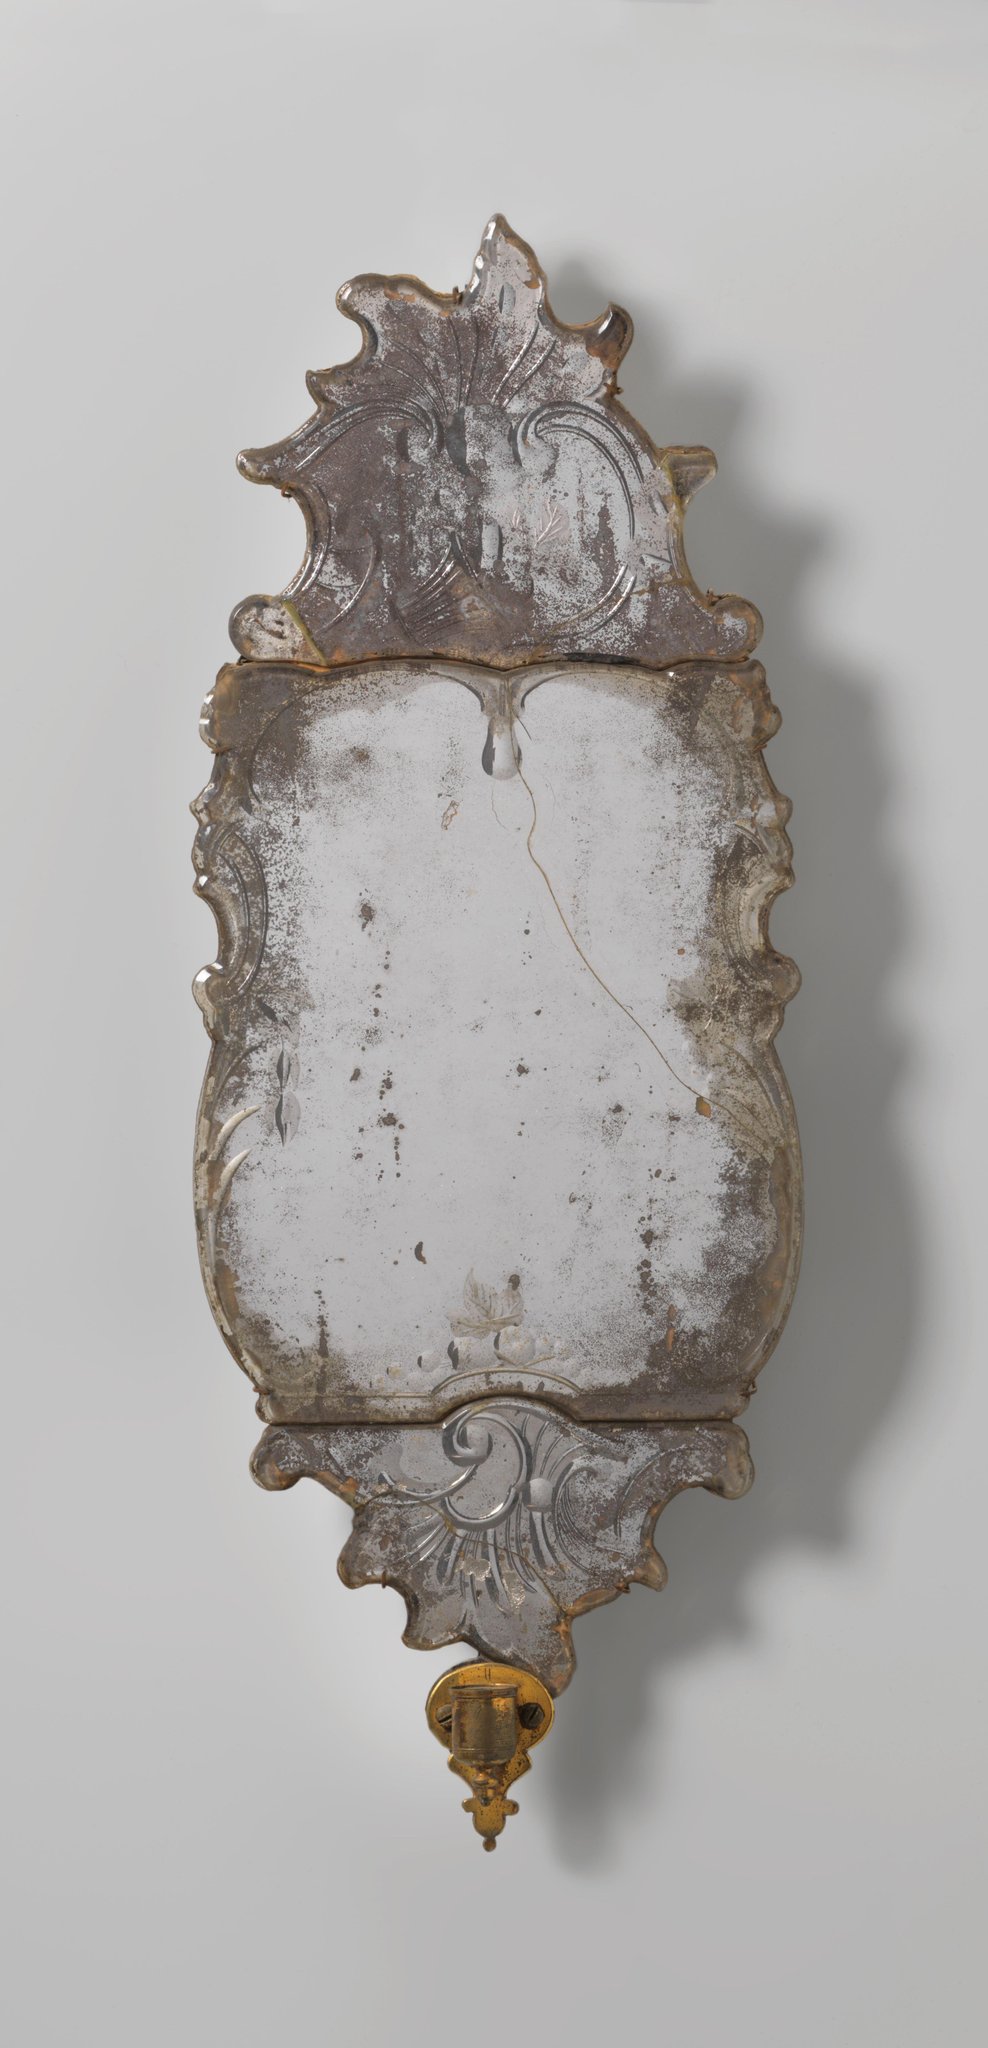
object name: furniture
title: Spiegel met geslepen glazen rand, bijbehorende luchter.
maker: Anonymous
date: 1600-1699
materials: amalgam, glass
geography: netherlands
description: Spiegel met een geslepen glazen rand met bijbehorende glazen luchter of luster (zie: BK-NM-3938-b).